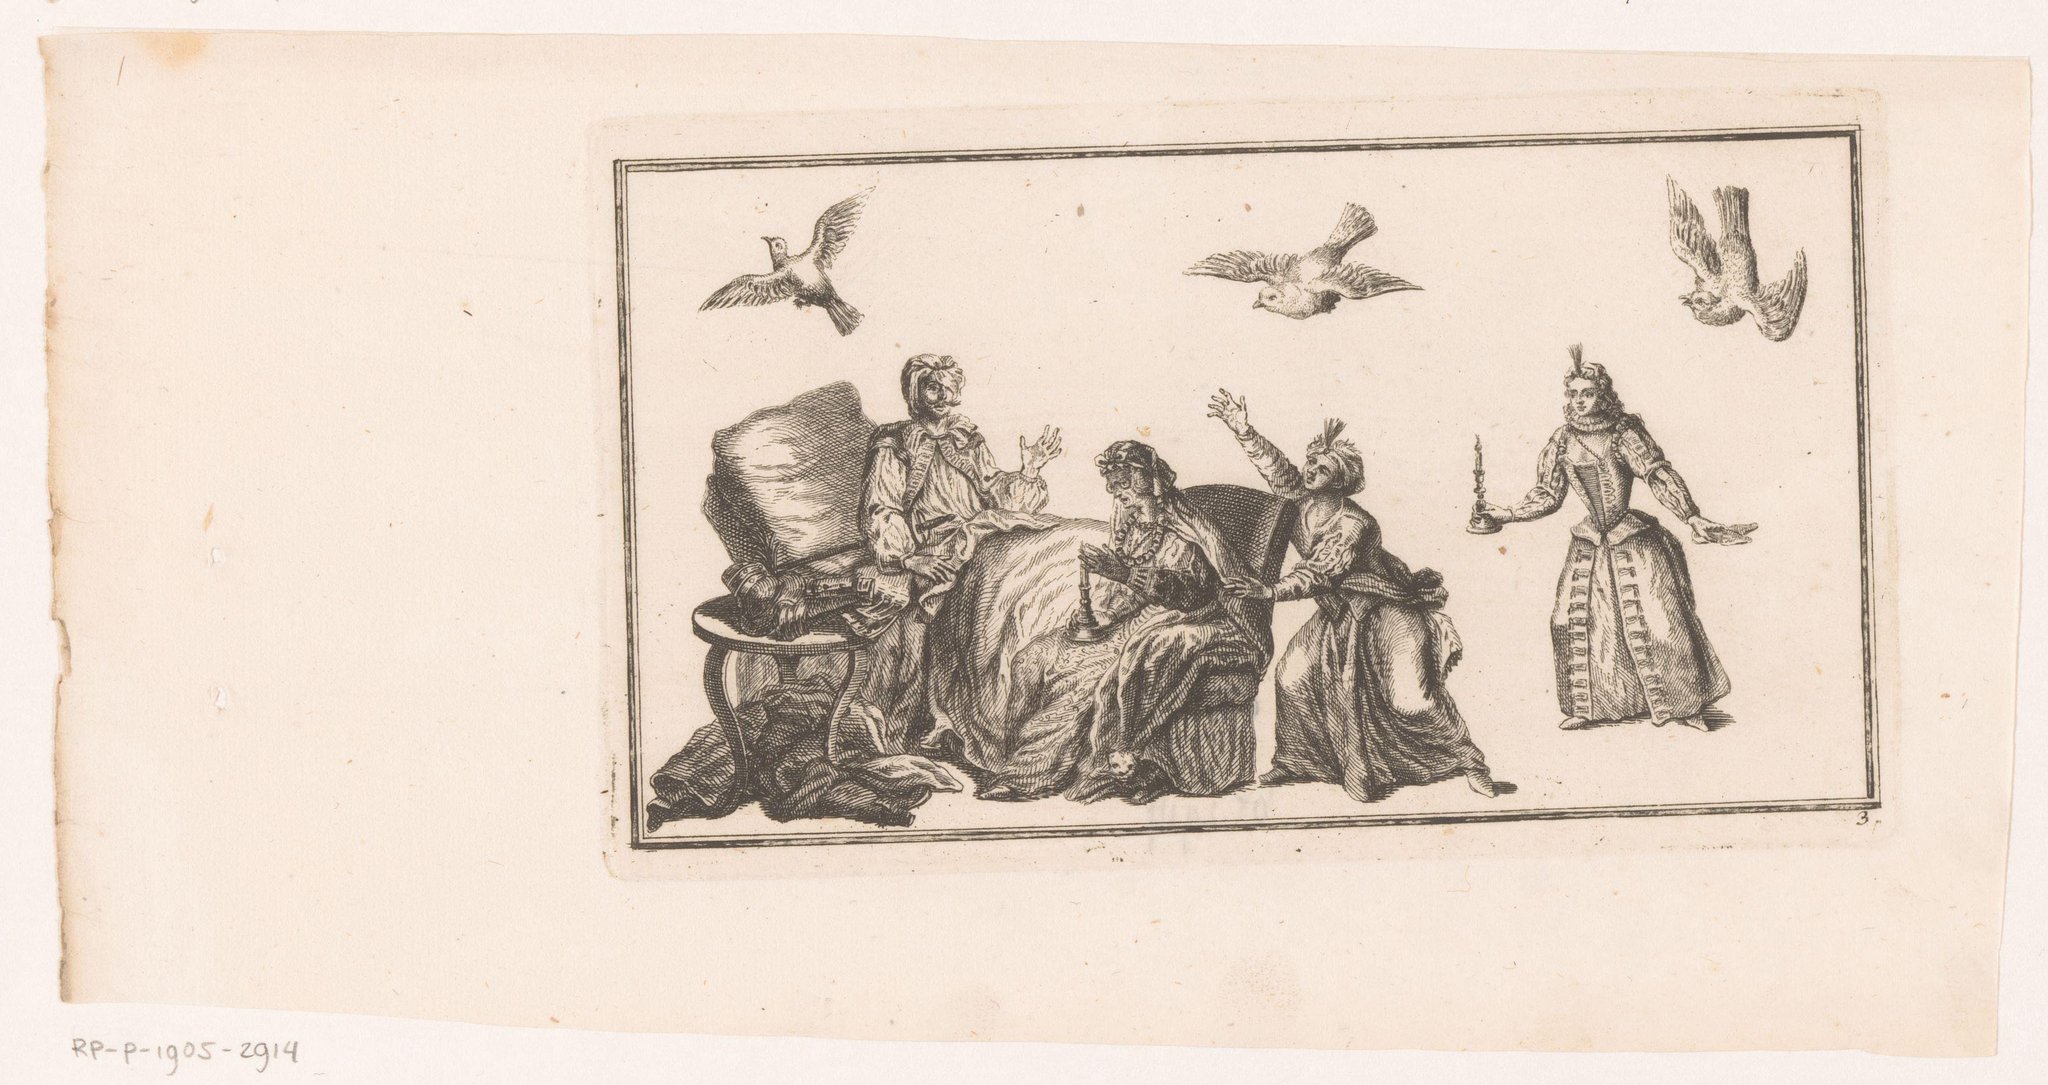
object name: print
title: Scène uit het verhaal van Don Quichot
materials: paper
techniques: etching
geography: nuremberg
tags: birds, don quixote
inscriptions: collector's mark: Lugt 2228